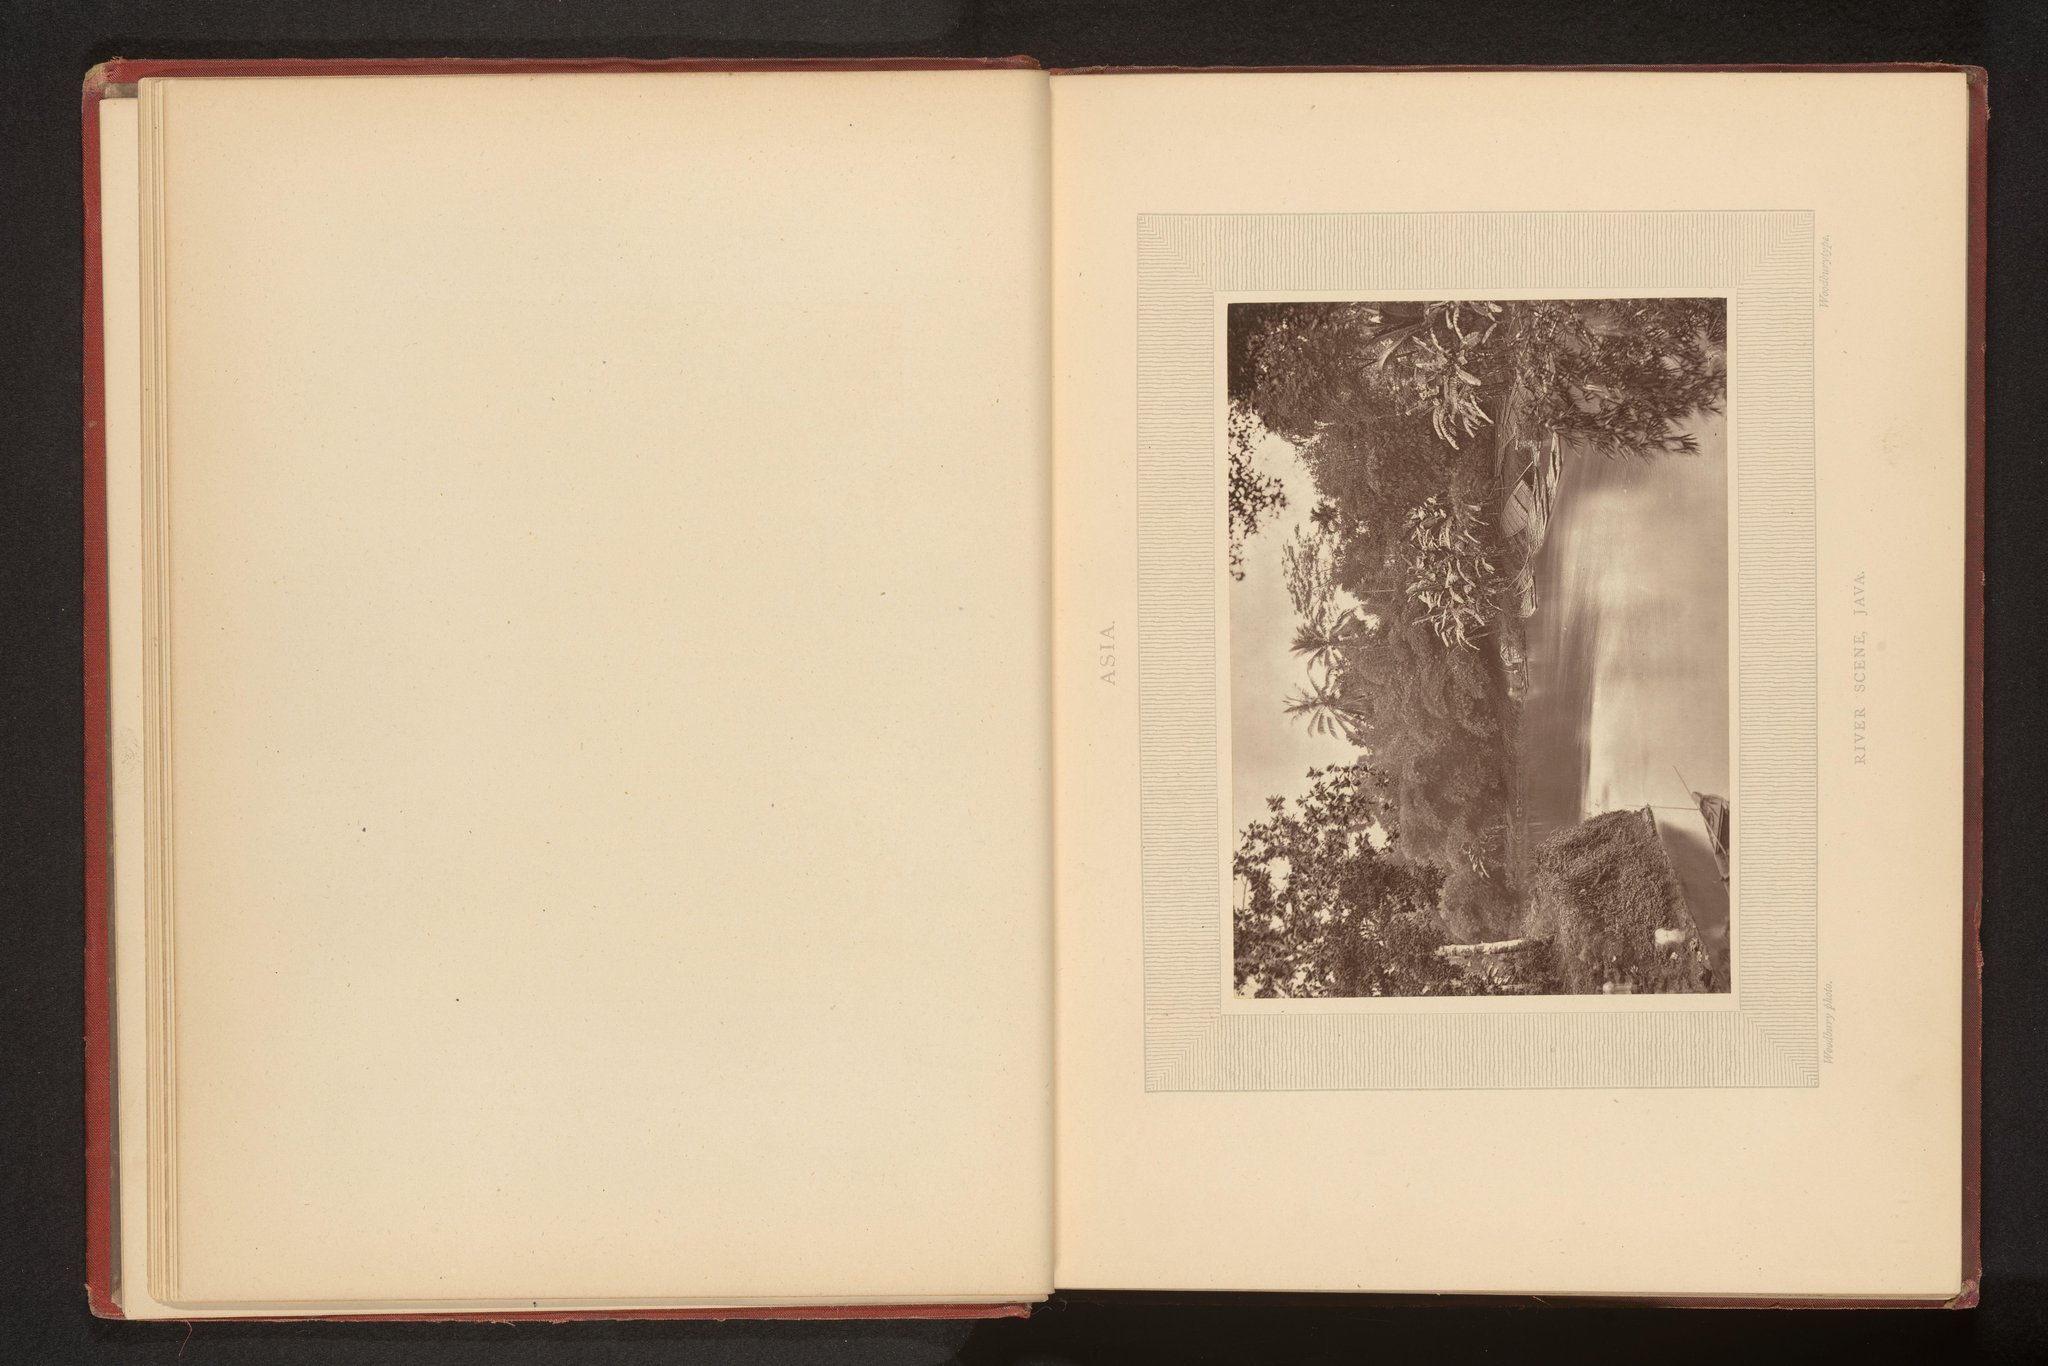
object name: photomechanical print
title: River scene, Java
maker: walter bentley woodbury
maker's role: fotograaf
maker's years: 1834-1885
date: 1870-1875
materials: cardboard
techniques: woodburytype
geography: java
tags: river, java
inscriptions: inscription: ‘Asia’, inscription: ‘Woodbury photo.’